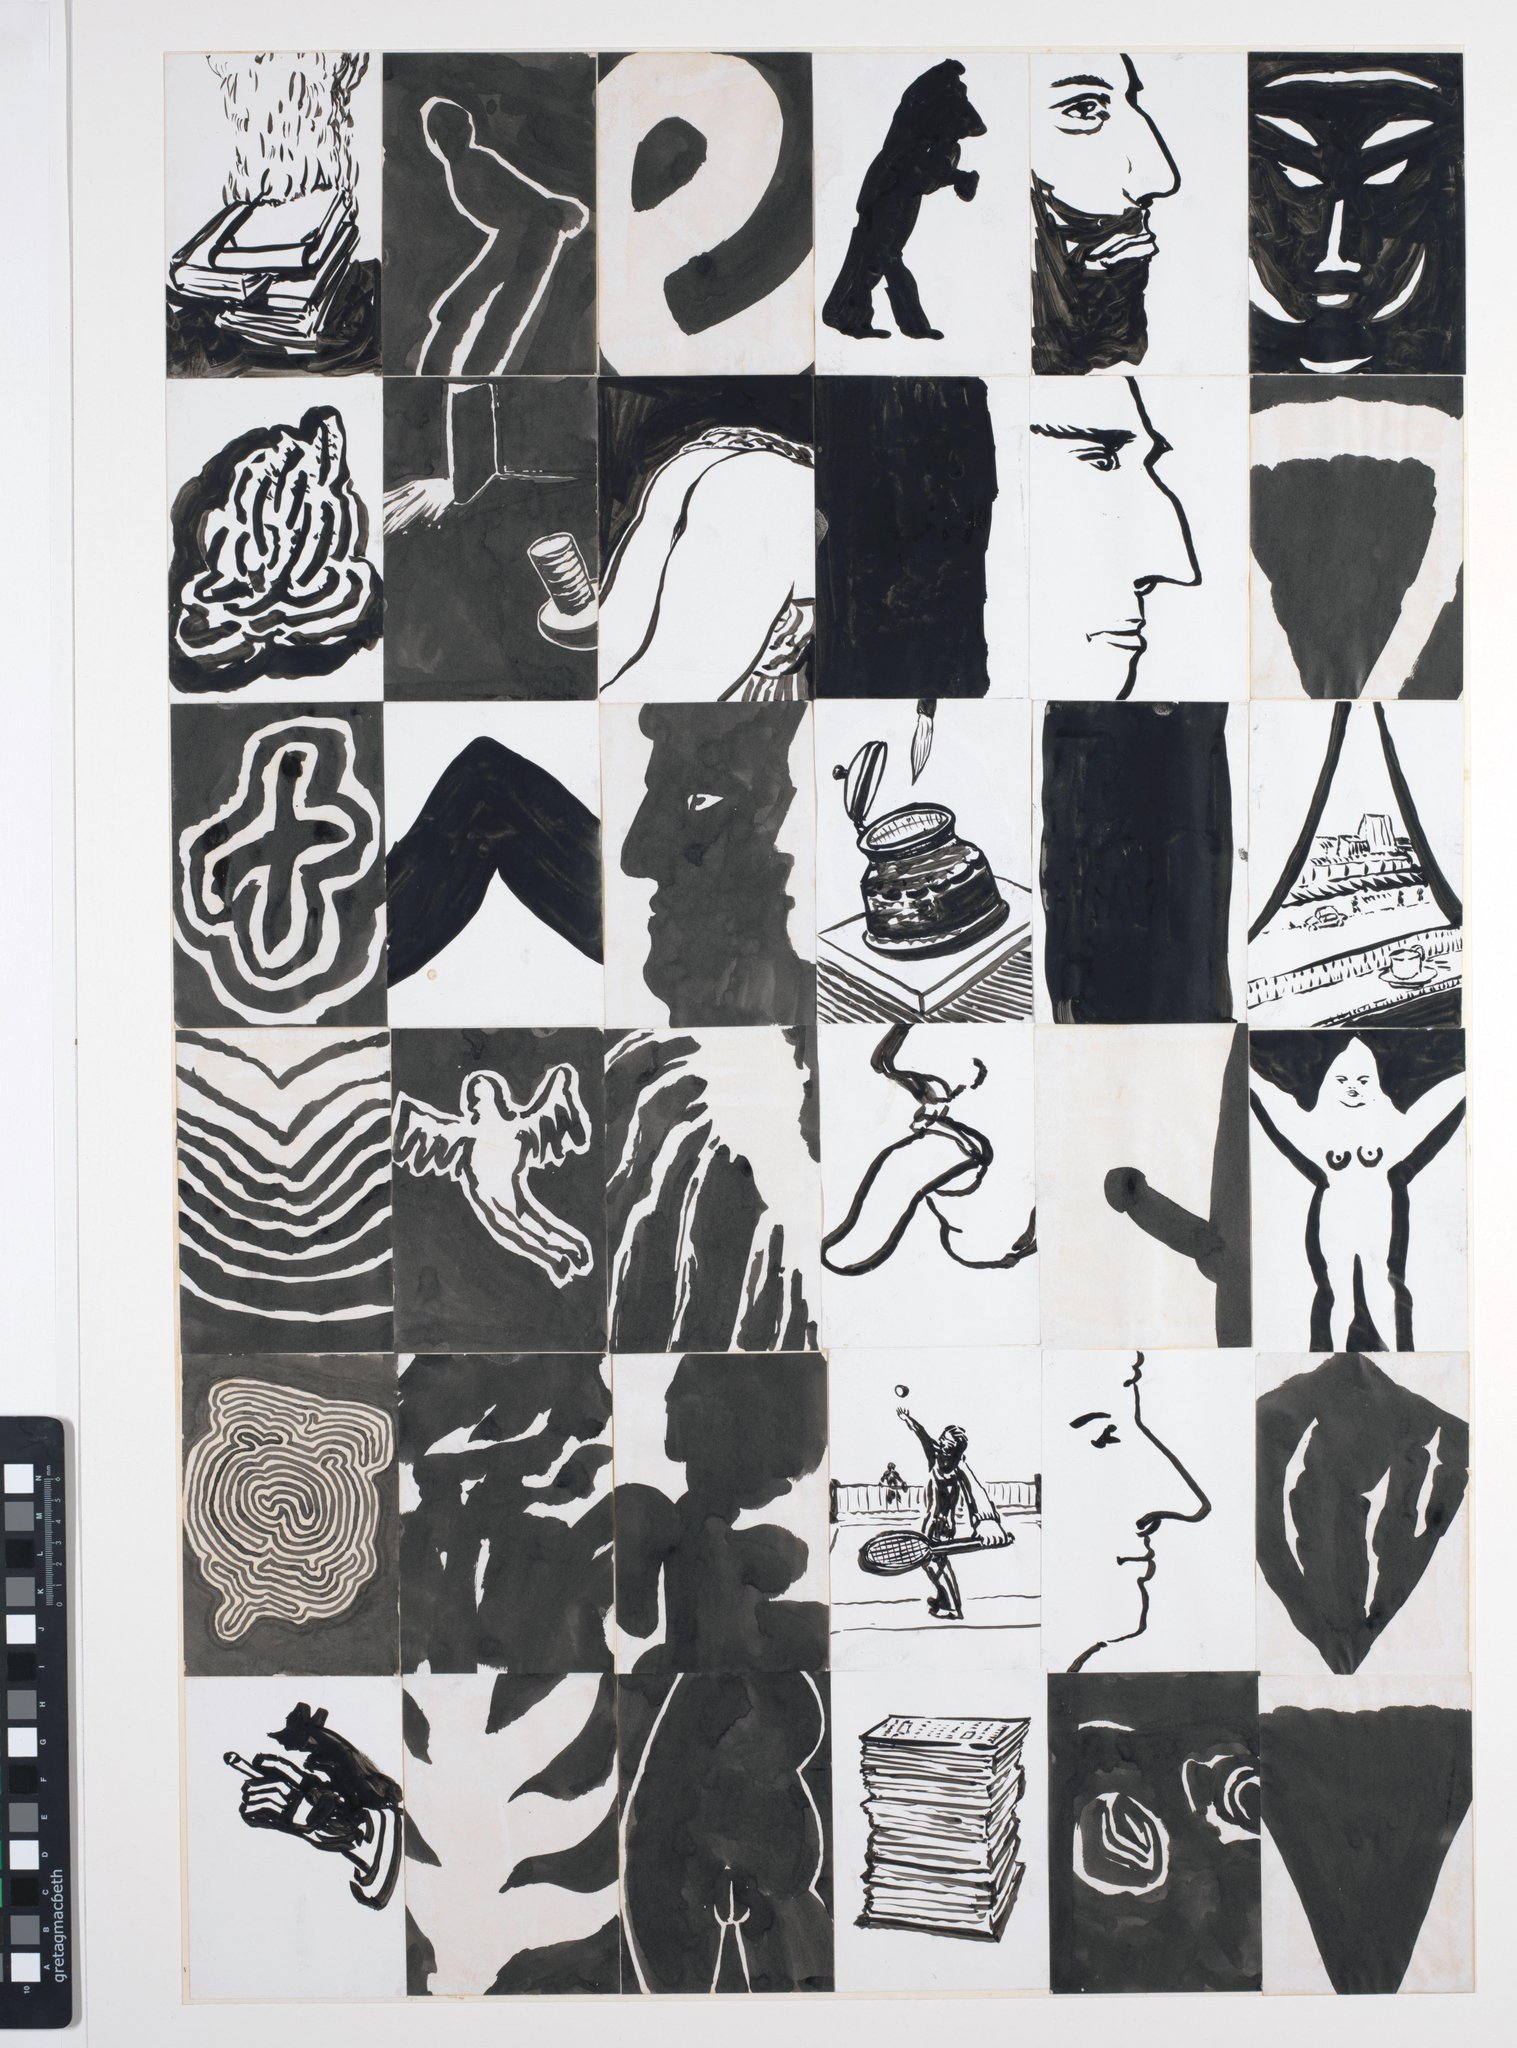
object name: drawing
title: 36 voorstellingen, waaronder engel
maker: pieter holstein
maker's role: draughtsman, painter, print maker, sculptor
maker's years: 1934-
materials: ink, paper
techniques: brush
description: 36 voorstellingen binnen vierkanten, waaronder een engel, masker en tenisser.